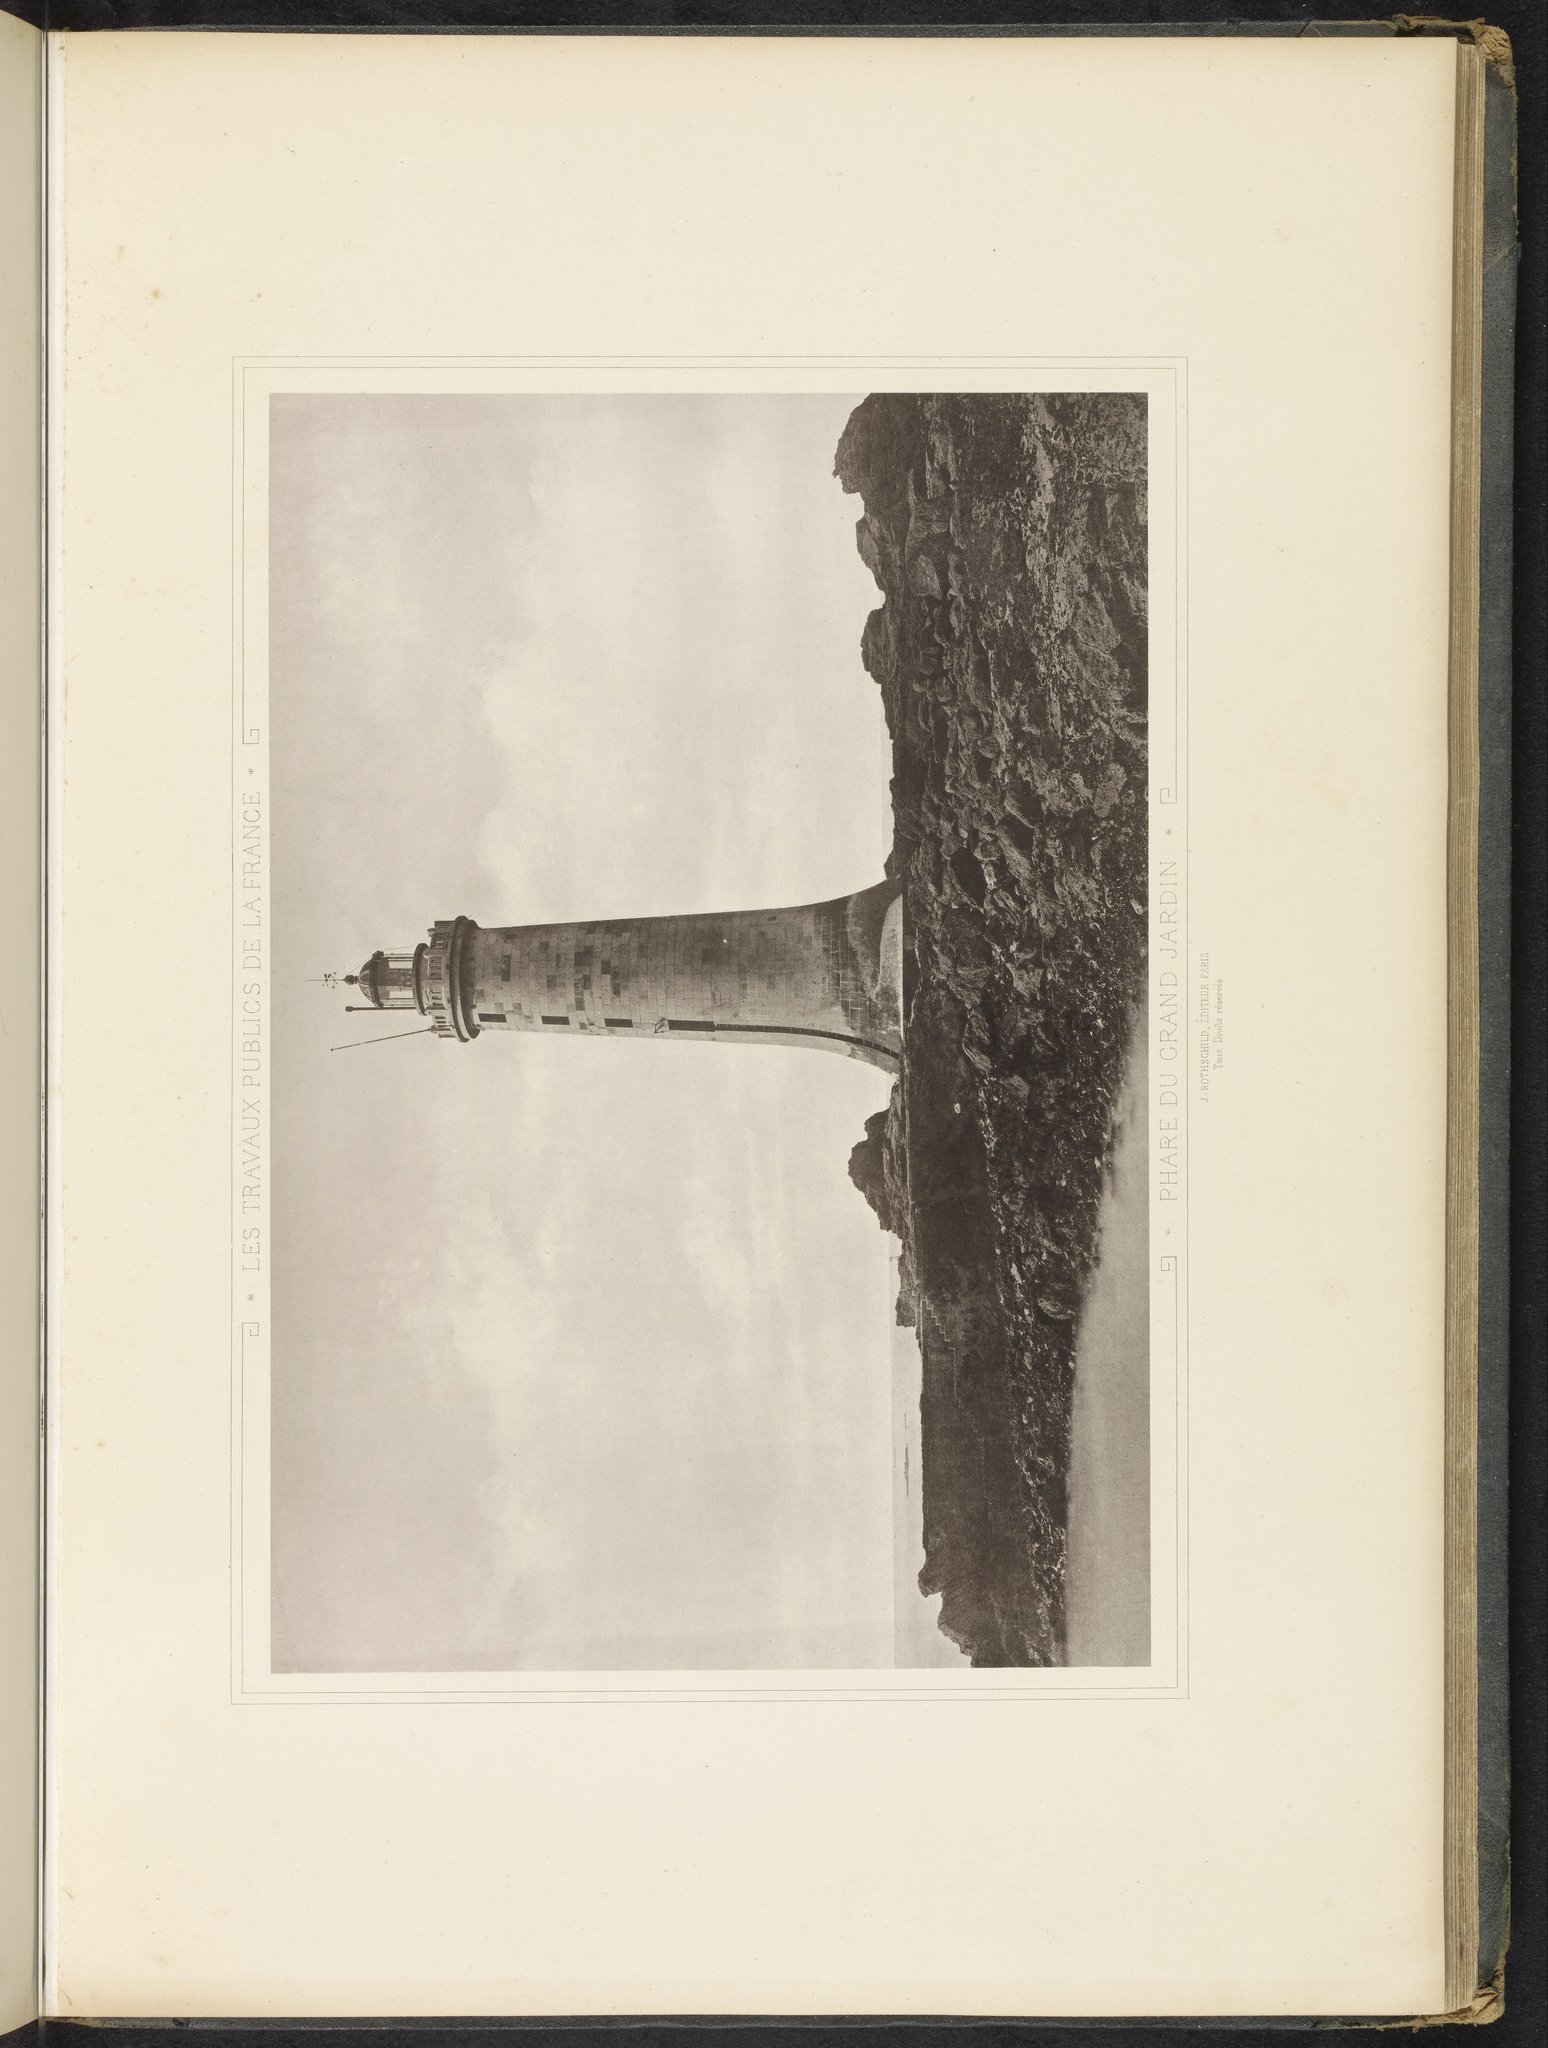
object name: photomechanical print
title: Phare du Grand Jardin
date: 1873-1883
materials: paper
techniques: photograph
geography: paris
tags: lighthouse, lightship